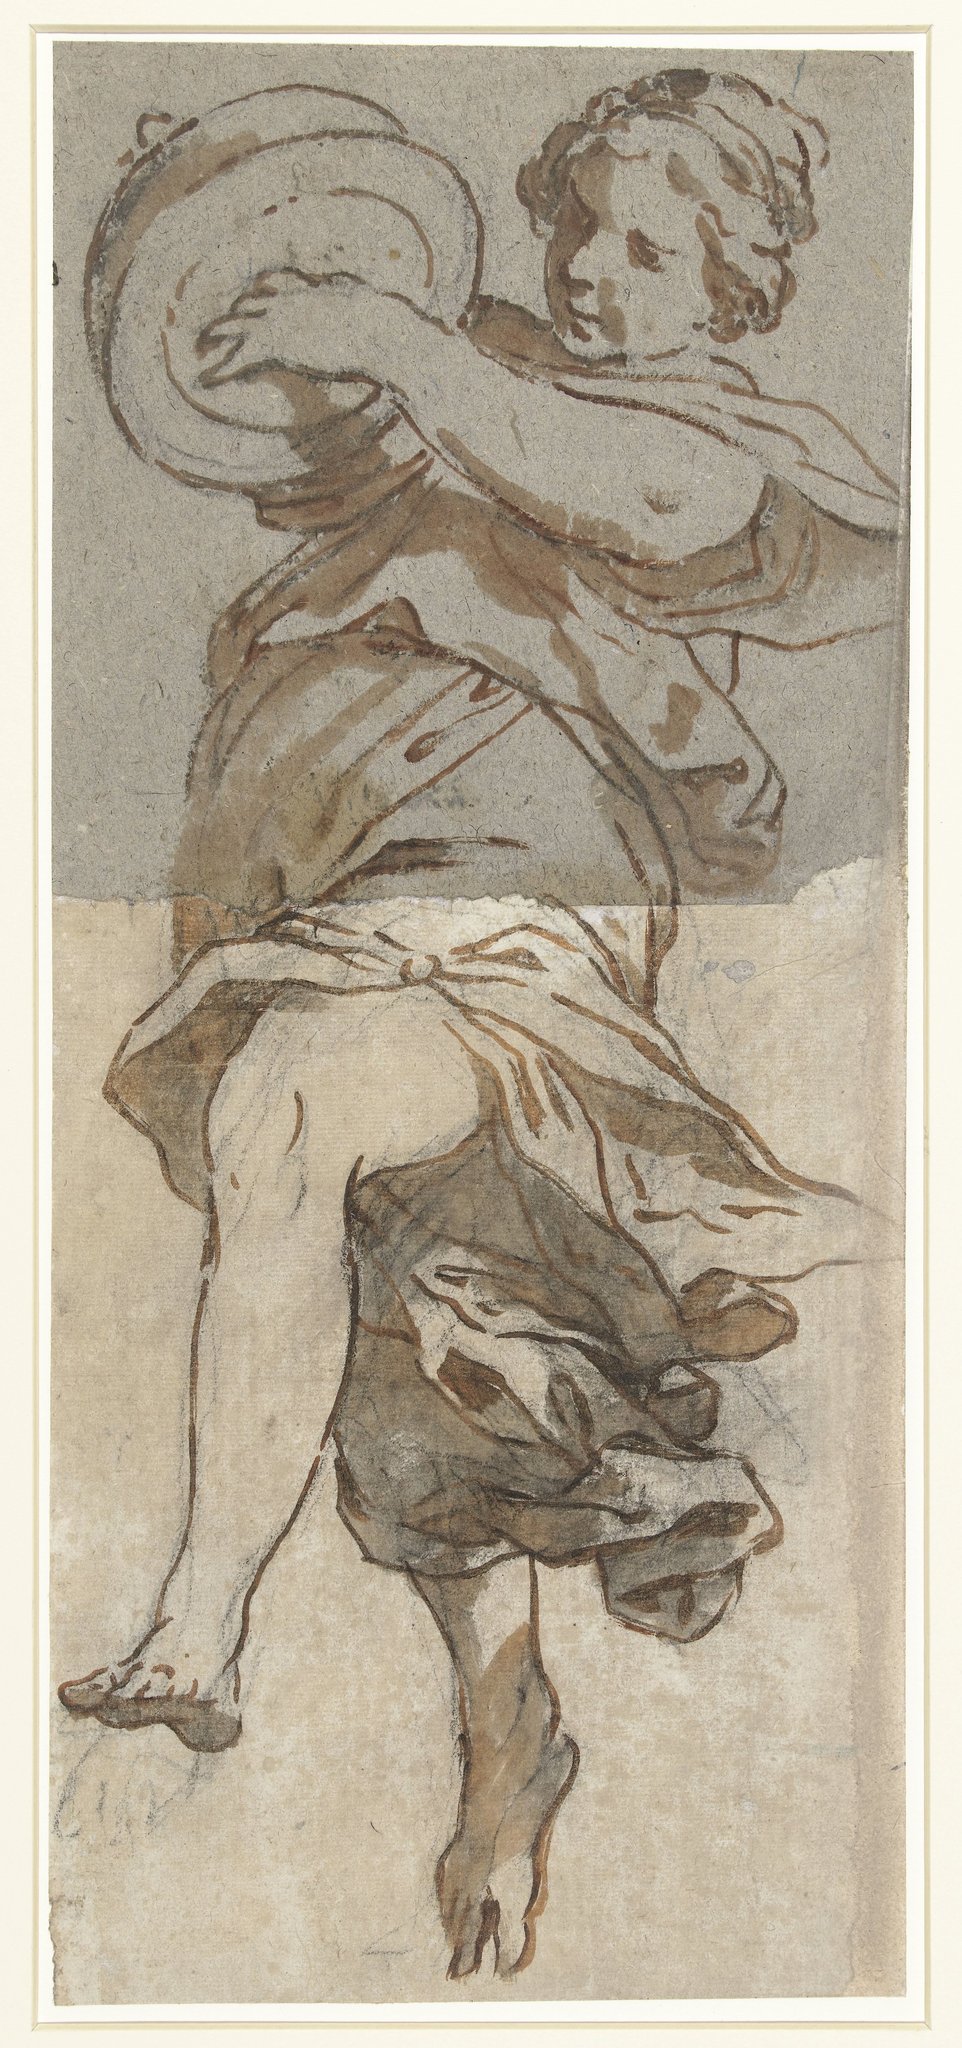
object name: drawing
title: Dansende vrouw met bekkens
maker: pietro da cortona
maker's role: designer, draughtsman, painter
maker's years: 1596-1669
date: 1640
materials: chalk, ink, paper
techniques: brush, pen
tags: woman dancing alone, other percussion instruments, one person playing percussion instrument